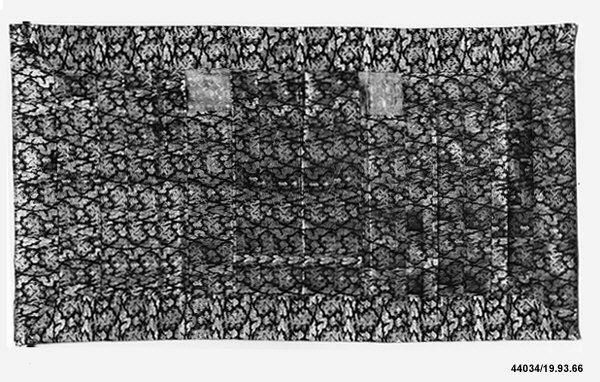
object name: robe, priest's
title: Priest's Robe (Shichijō)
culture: japanese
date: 1688-1704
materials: metal thread, silk